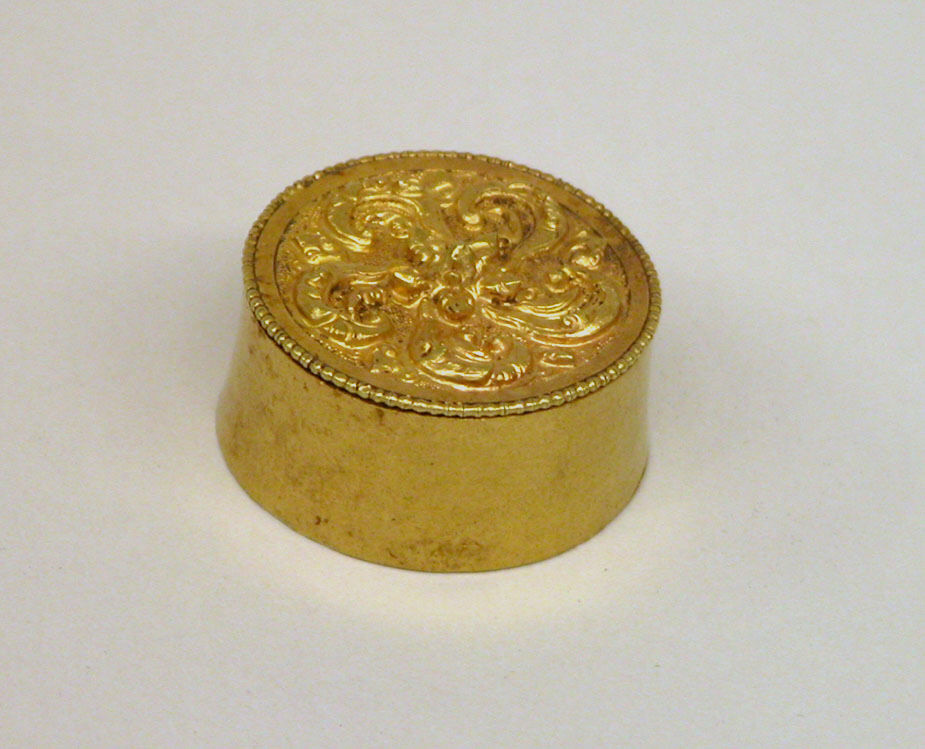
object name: ear plug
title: Subang (Ear Plug) with Foliate Design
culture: indonesian, javanese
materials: gold